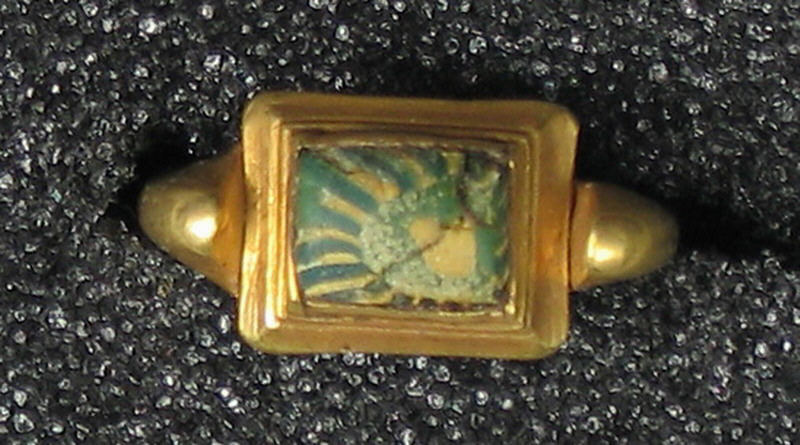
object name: ring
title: Ring, Rectanglular Bezel with Glass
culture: indonesian, central java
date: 701-1200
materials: gold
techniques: casting